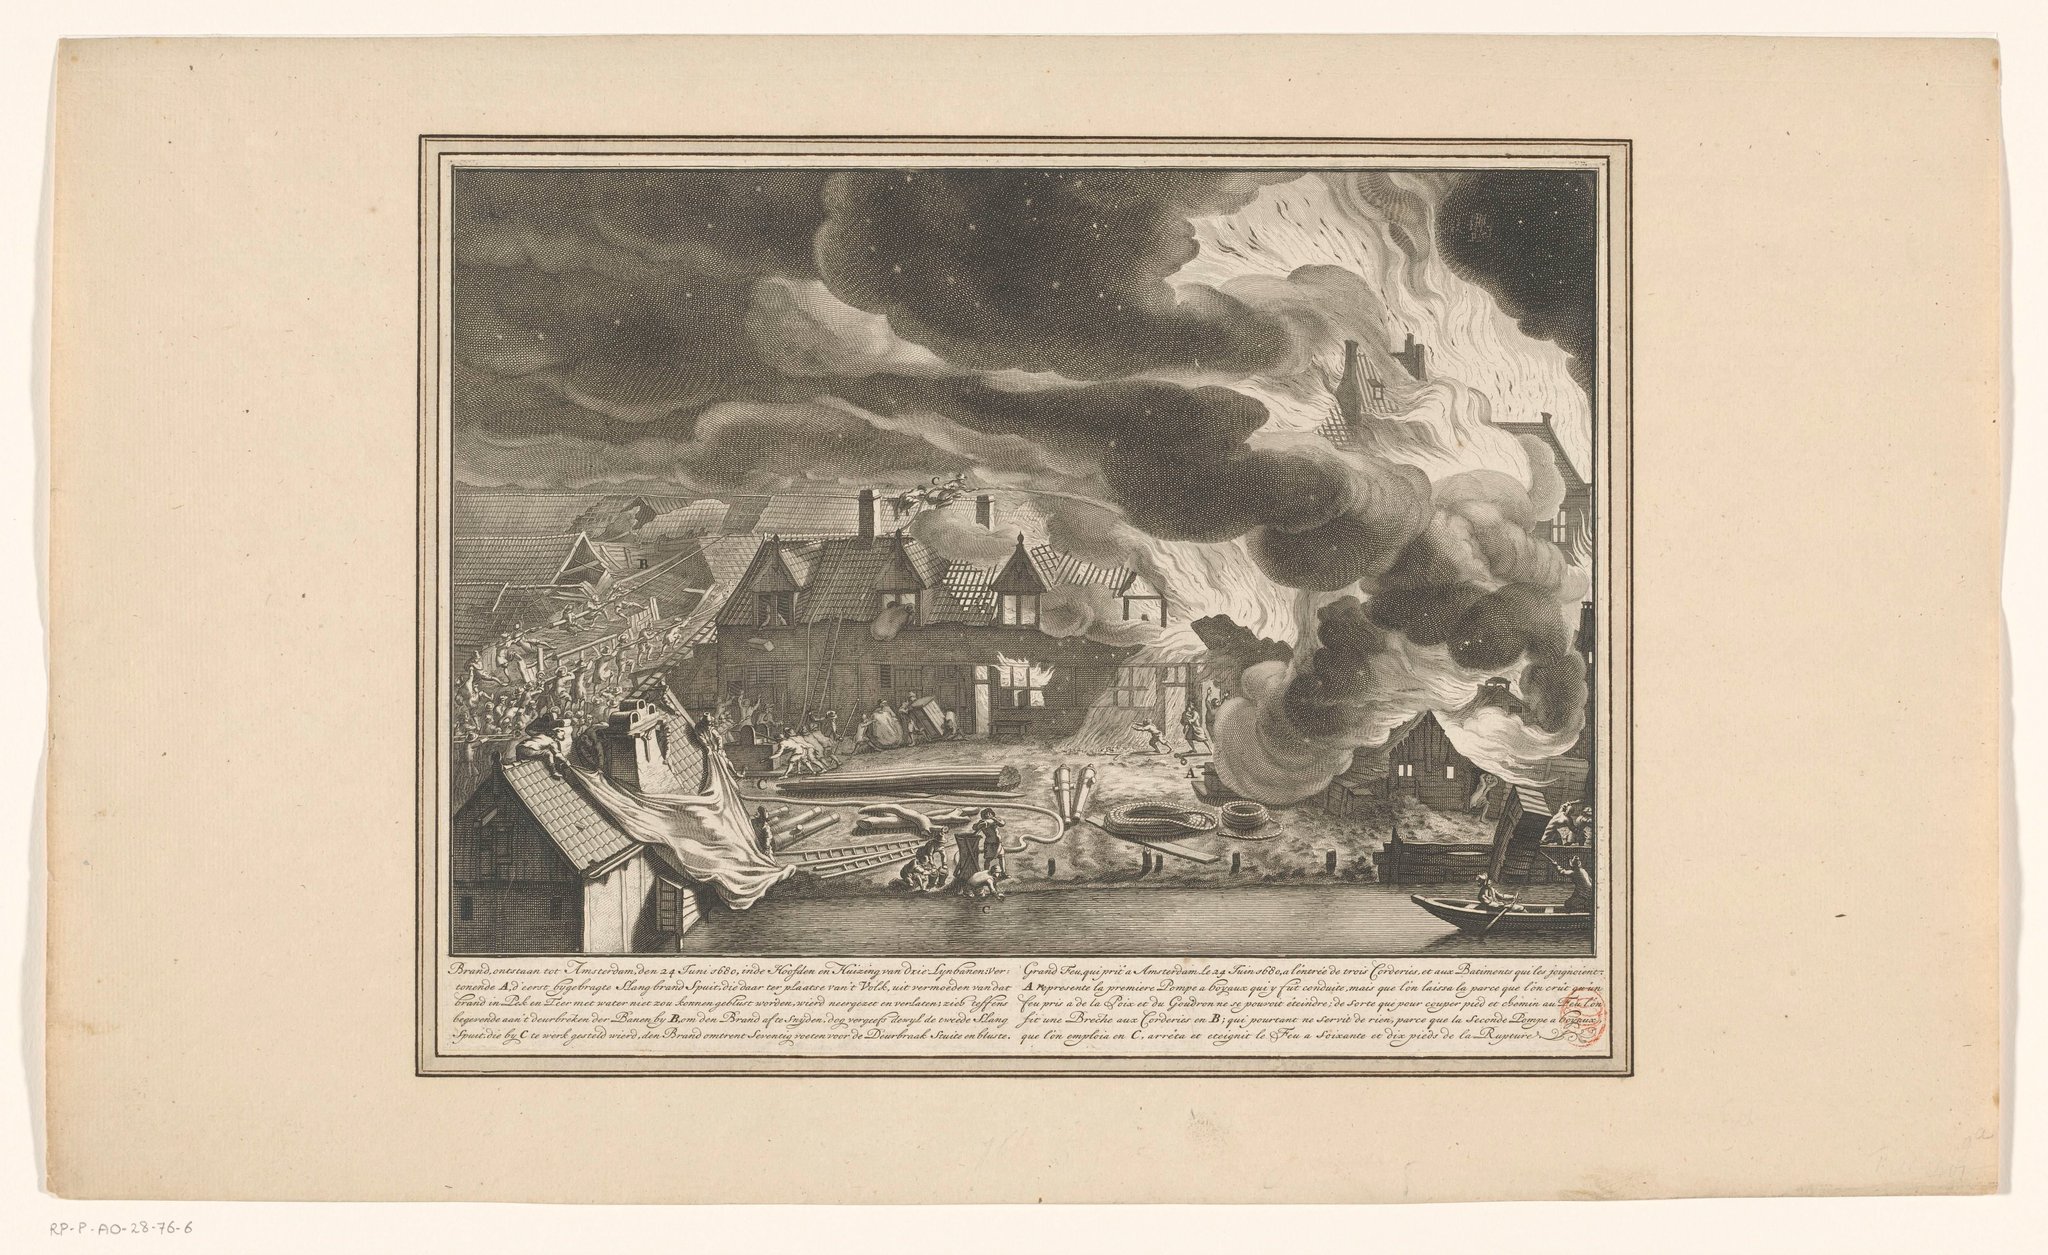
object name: book illustration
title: Brand, ontstaan tot Amsterdam, den 24 juni 1680, inde hoofden en huizing van drie lynbanen (…) / Grand feu, qui prit a Amsterdam le 24 juin 1680, a l'entrée de trois corderies, et aux batiments qui les joignoient (…)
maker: jan van der heyden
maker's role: draughtsman, painter, print maker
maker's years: 1637-1712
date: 1690-1735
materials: paper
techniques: engraving, etching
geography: amsterdam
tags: painter, print maker, draughtsman, jan van der heyden, on fire, ablaze, fire-fighting, fire-extinguishing equipment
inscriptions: collector's mark: Lugt 2228, collector's mark: Lugt 195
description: Prent ook gebruikt in: Heyden, Jan van der. Beschryving der nieuwlyks uitgevonden en geoctrojeerde slang-brand-spuiten en haare wyze van brand-blussen, tegenwoordig binnen Amsterdam in gebruik zijnde (…). 1e druk. Amsterdam: Jan Rieuwertsz. (II), 1690. En in: Heyden, Jan van der. Beschryving der nieuwlyks uitgevonden en geoctrojeerde slang-brand-spuiten en haare wyze van brand-blussen, tegenwoordig binnen Amsterdam in gebruik zijnde (…). 2e druk. Amsterdam: erfgenamen Jan van der Heyden, 1735. Voor eerdere staat, voor de letter, zie RP-P-1944-235.